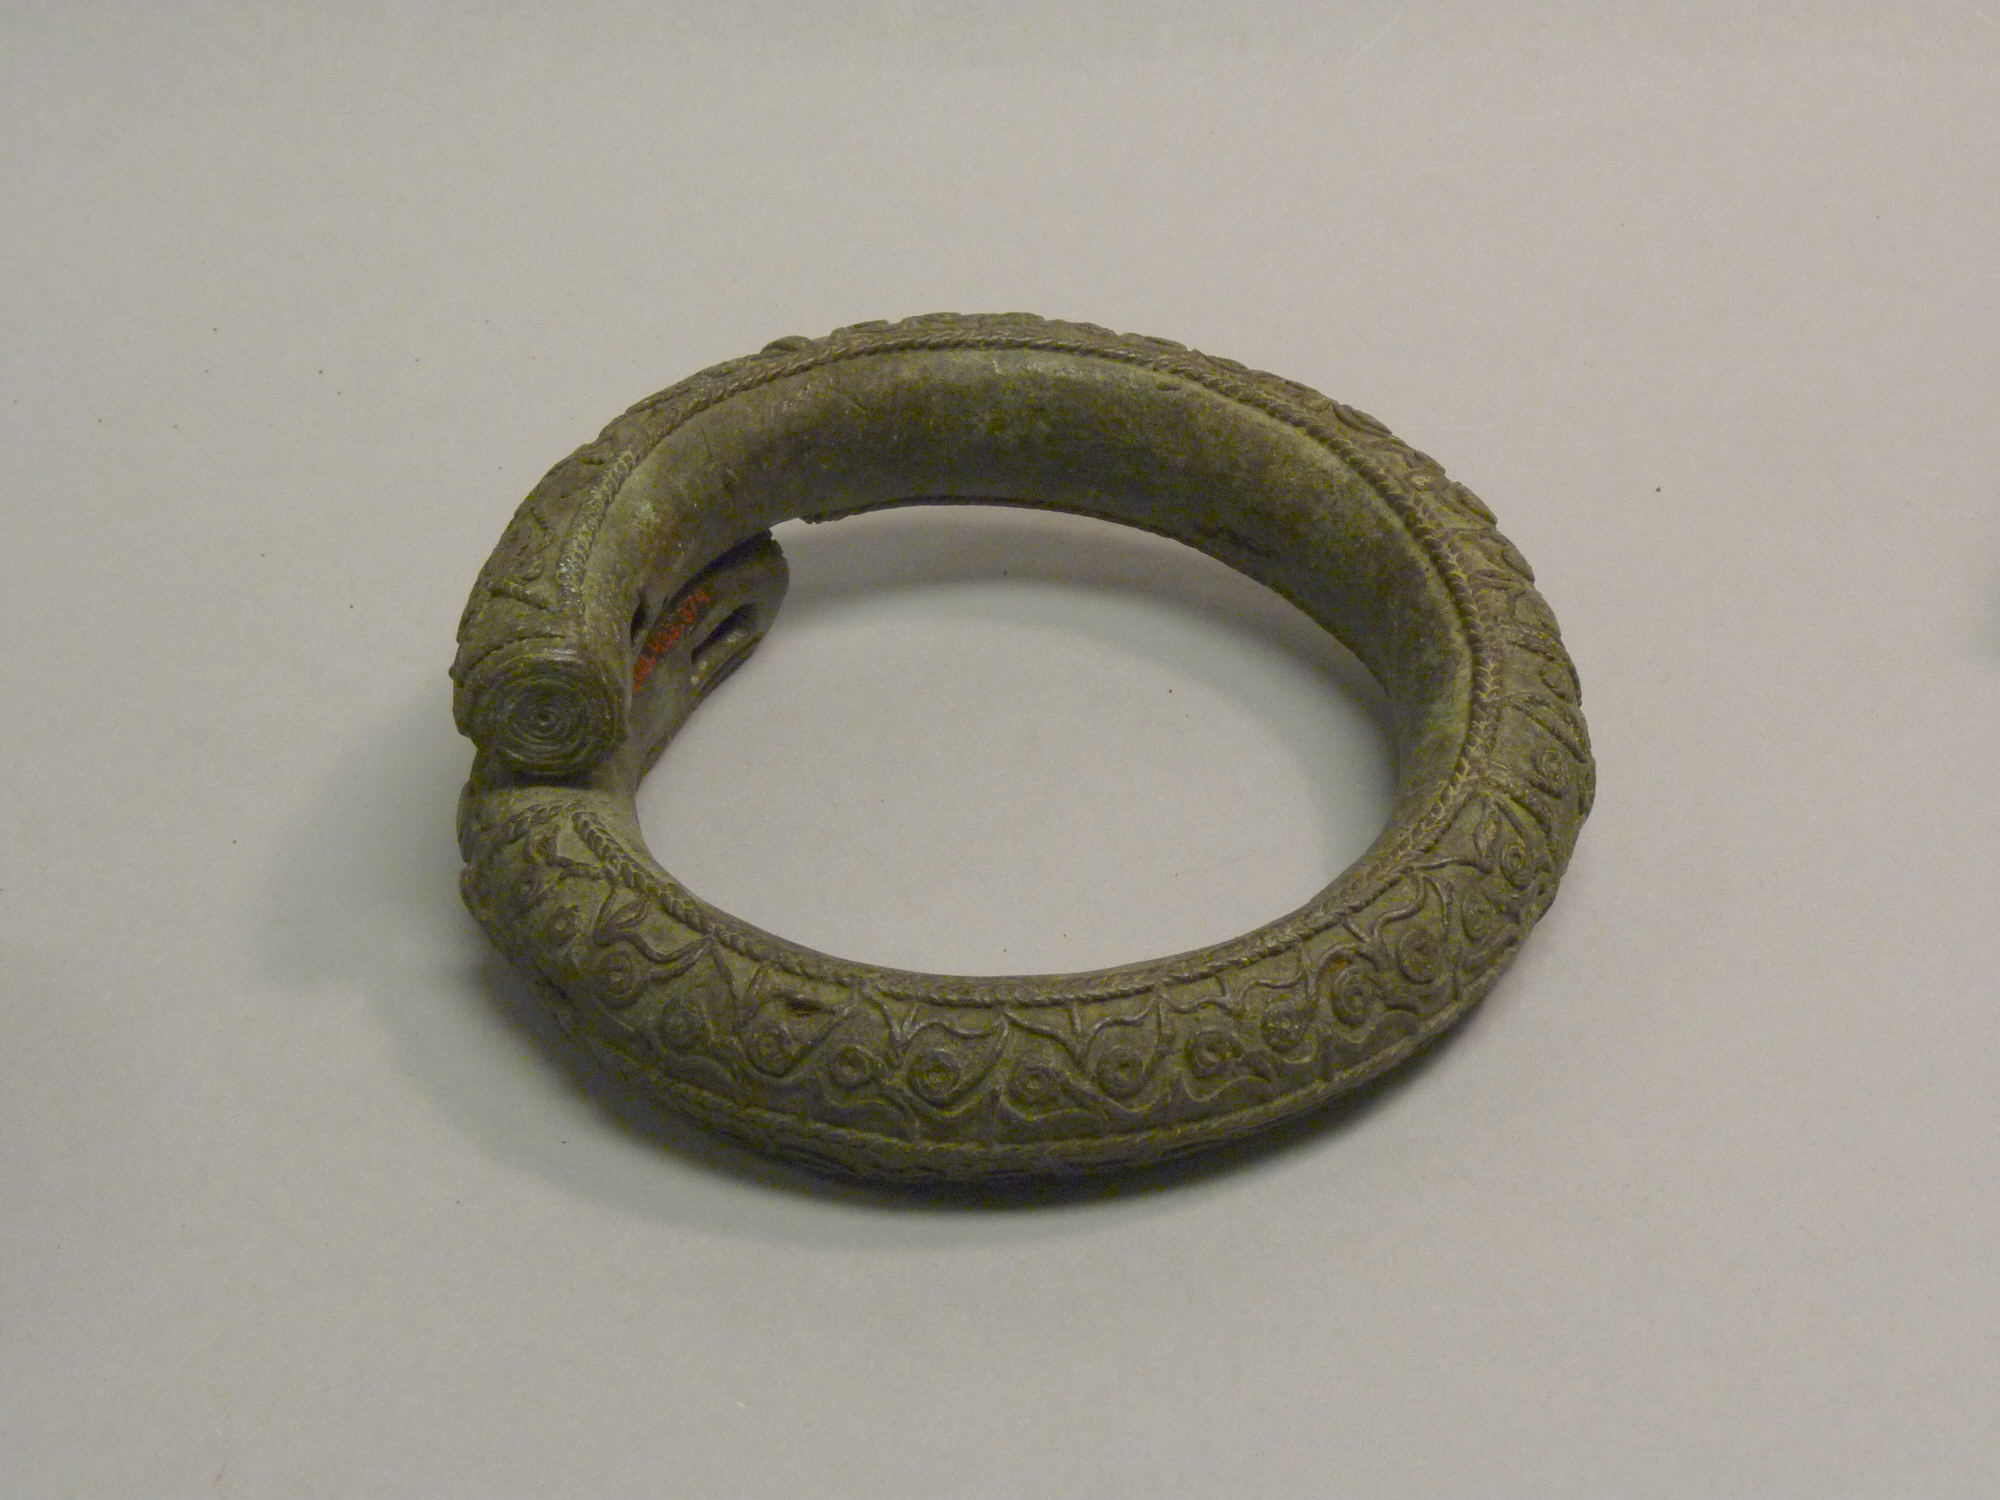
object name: anklet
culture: vietnamese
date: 500 BCE-300 CE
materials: bronze